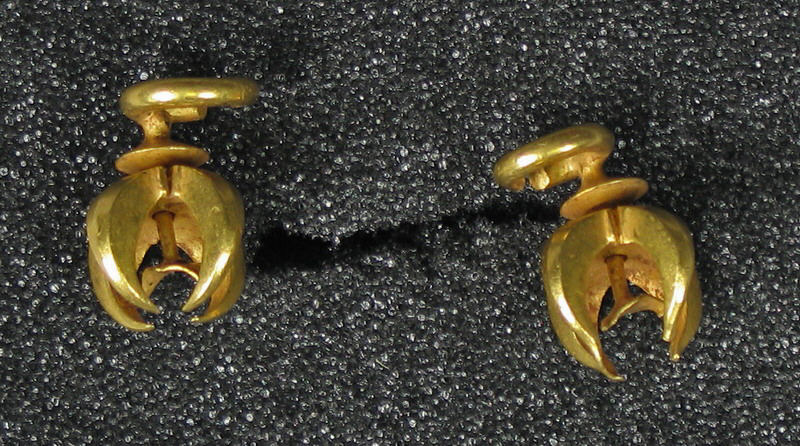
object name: pair of earring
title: Pair of Earrings in Cruciform Shape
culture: indonesian, central java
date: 701-1200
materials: gold